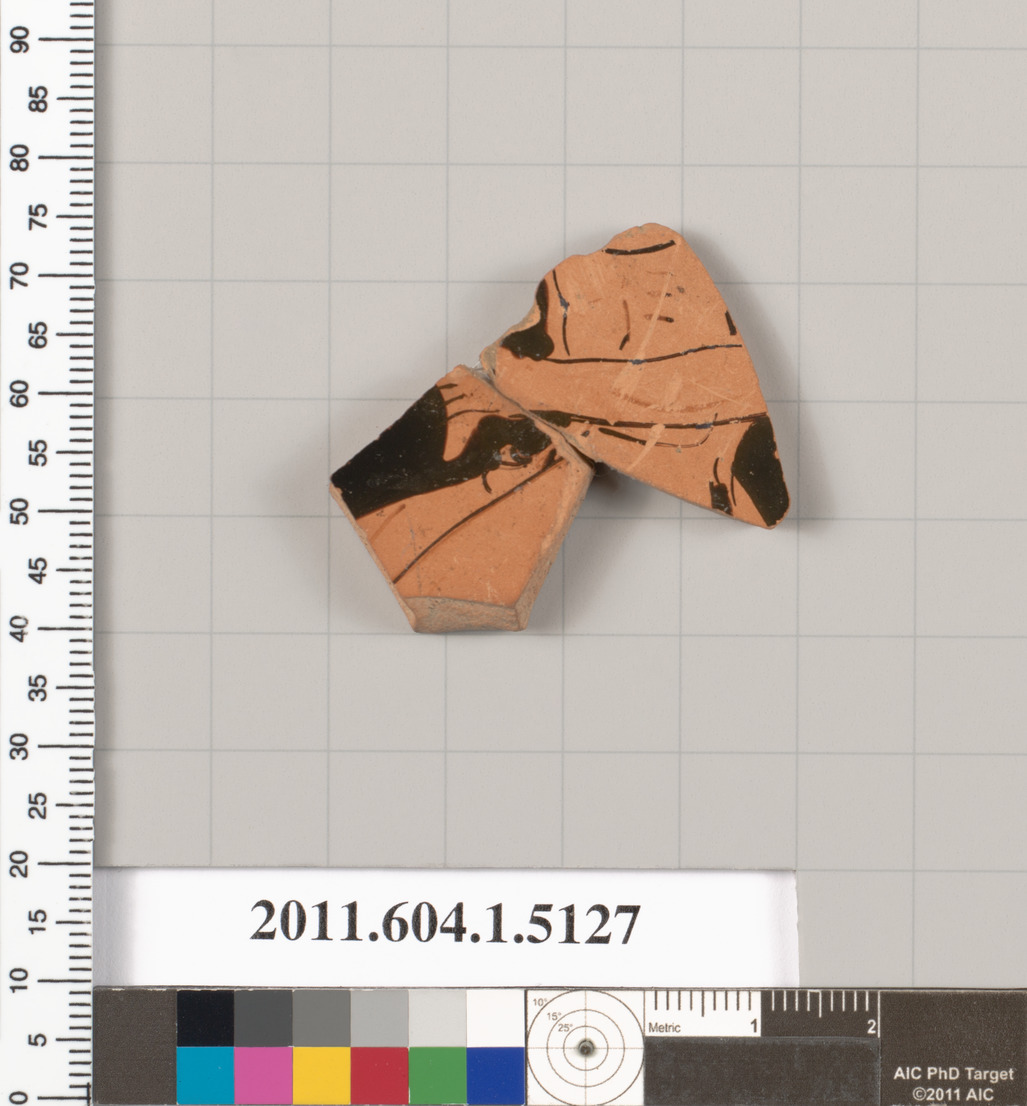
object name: kylix fragment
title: Terracotta fragment of a kylix (drinking cup)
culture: greek, attic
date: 475-451 BCE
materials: terracotta